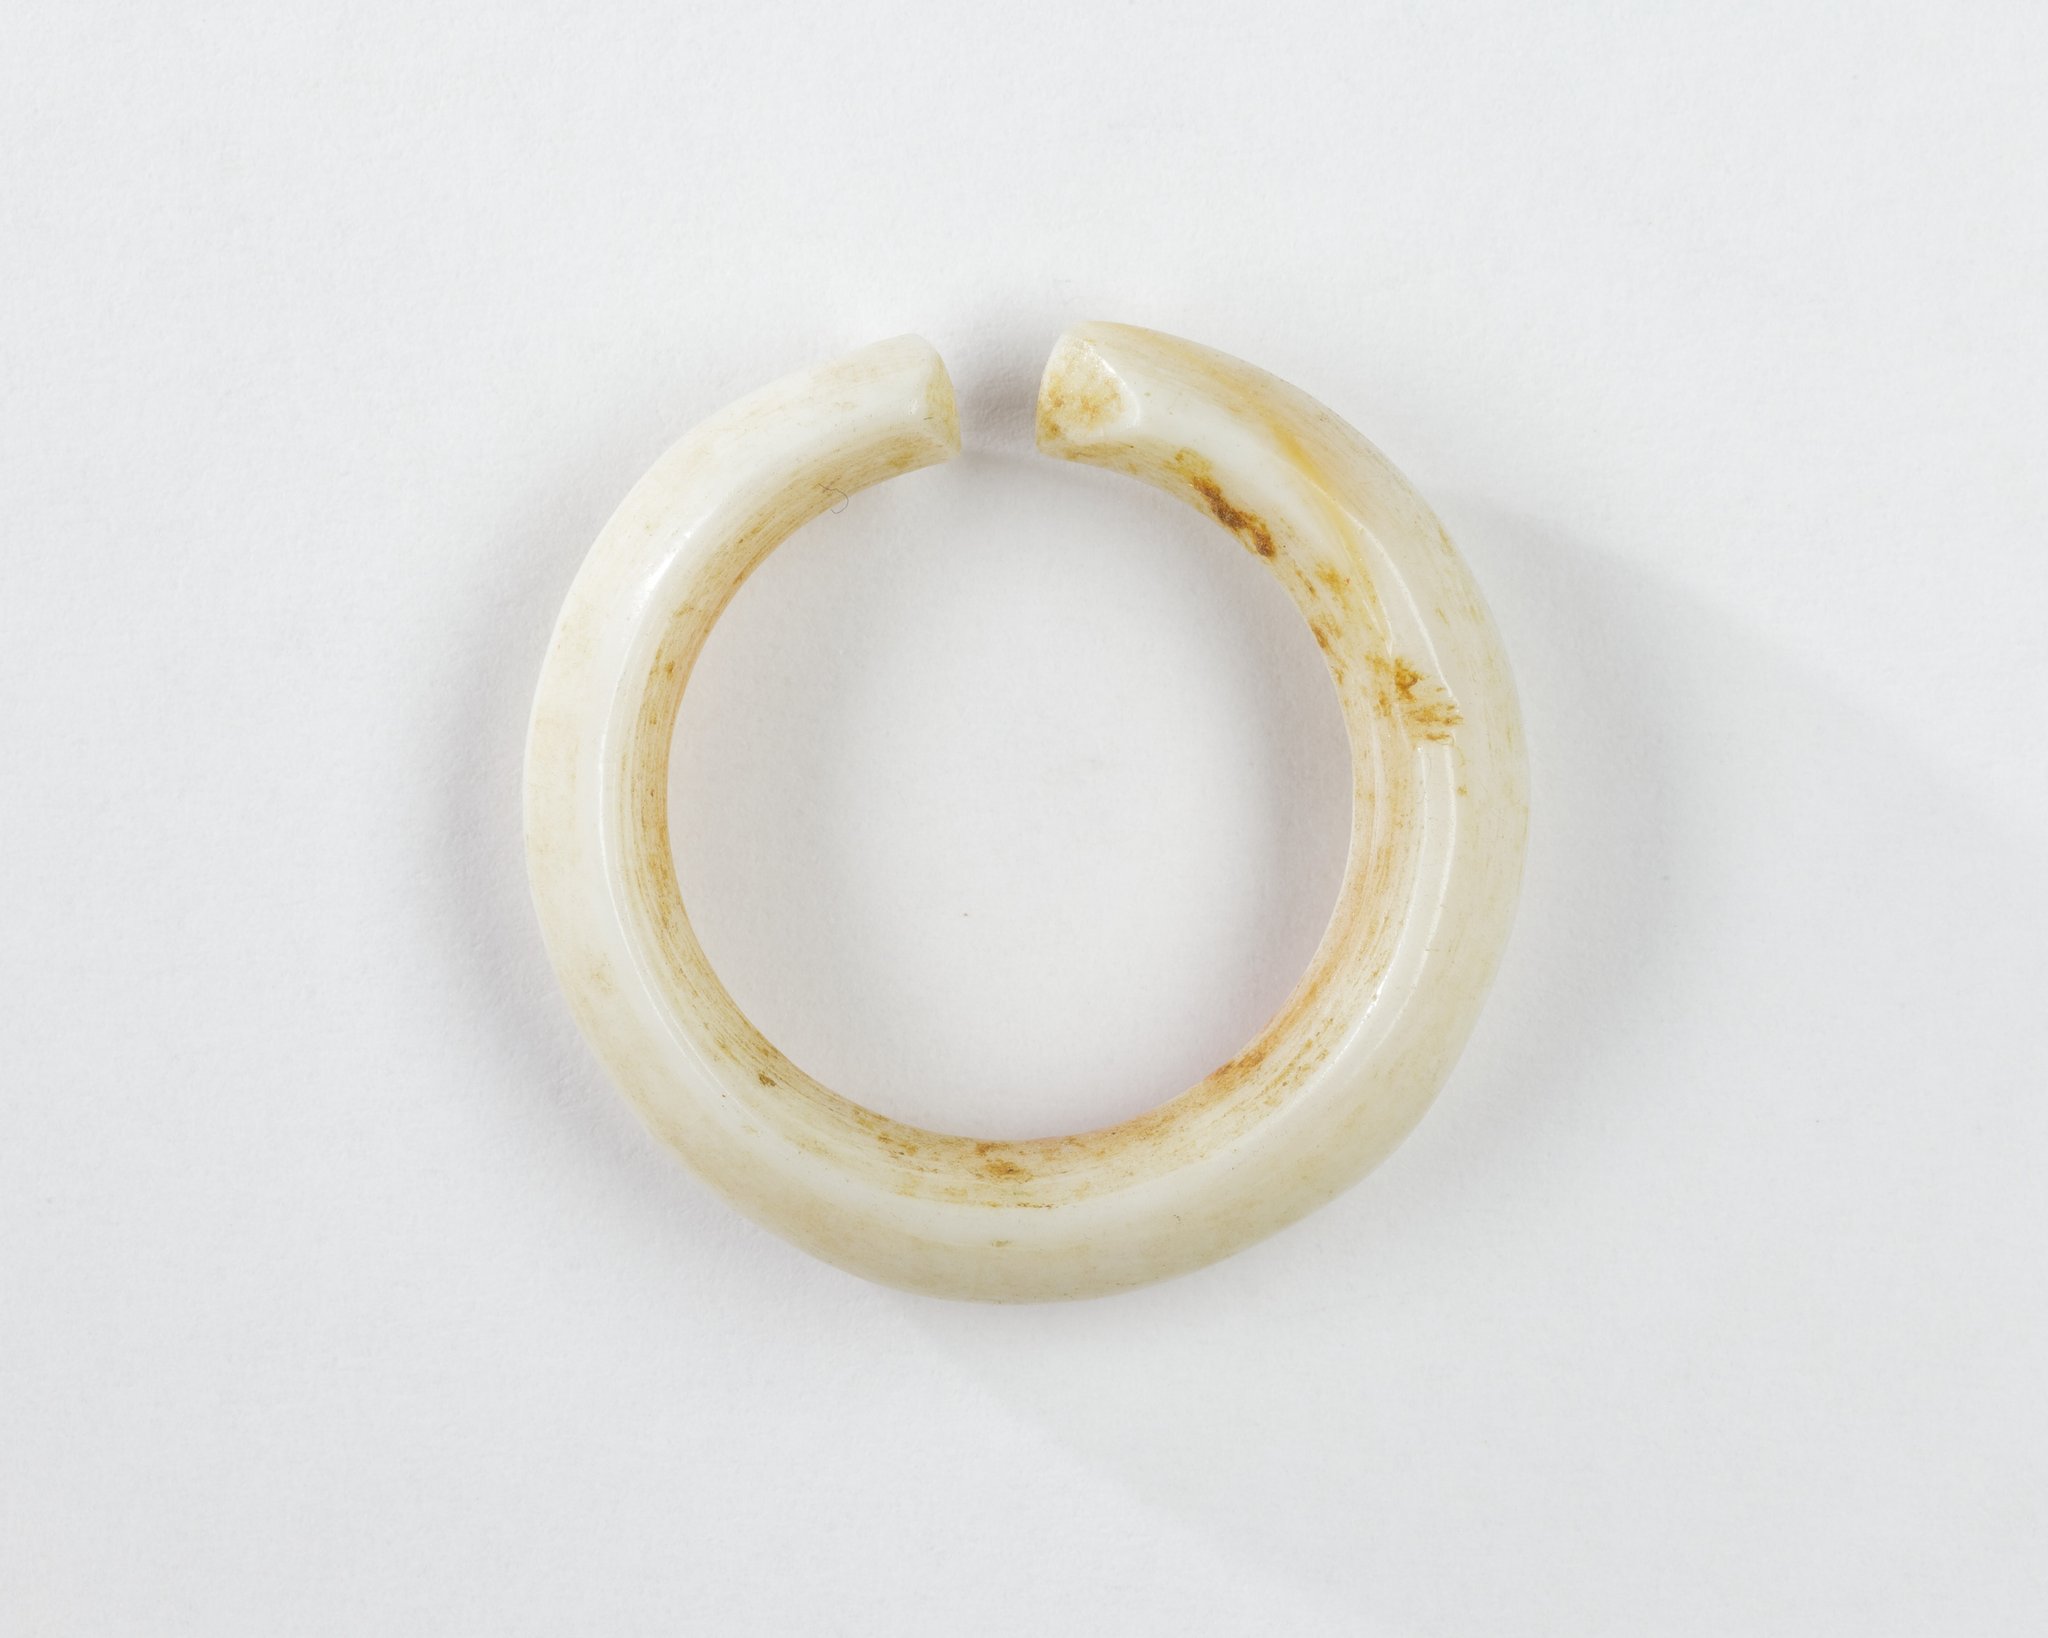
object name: earring, penannular, circular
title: Penannular Earring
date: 1550-1295 BCE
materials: shell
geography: northern upper egypt